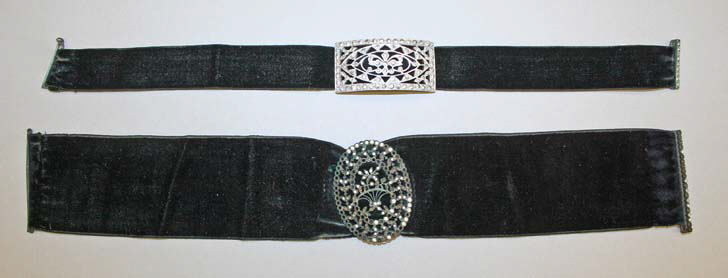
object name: neckcloth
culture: american or european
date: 1900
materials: metal